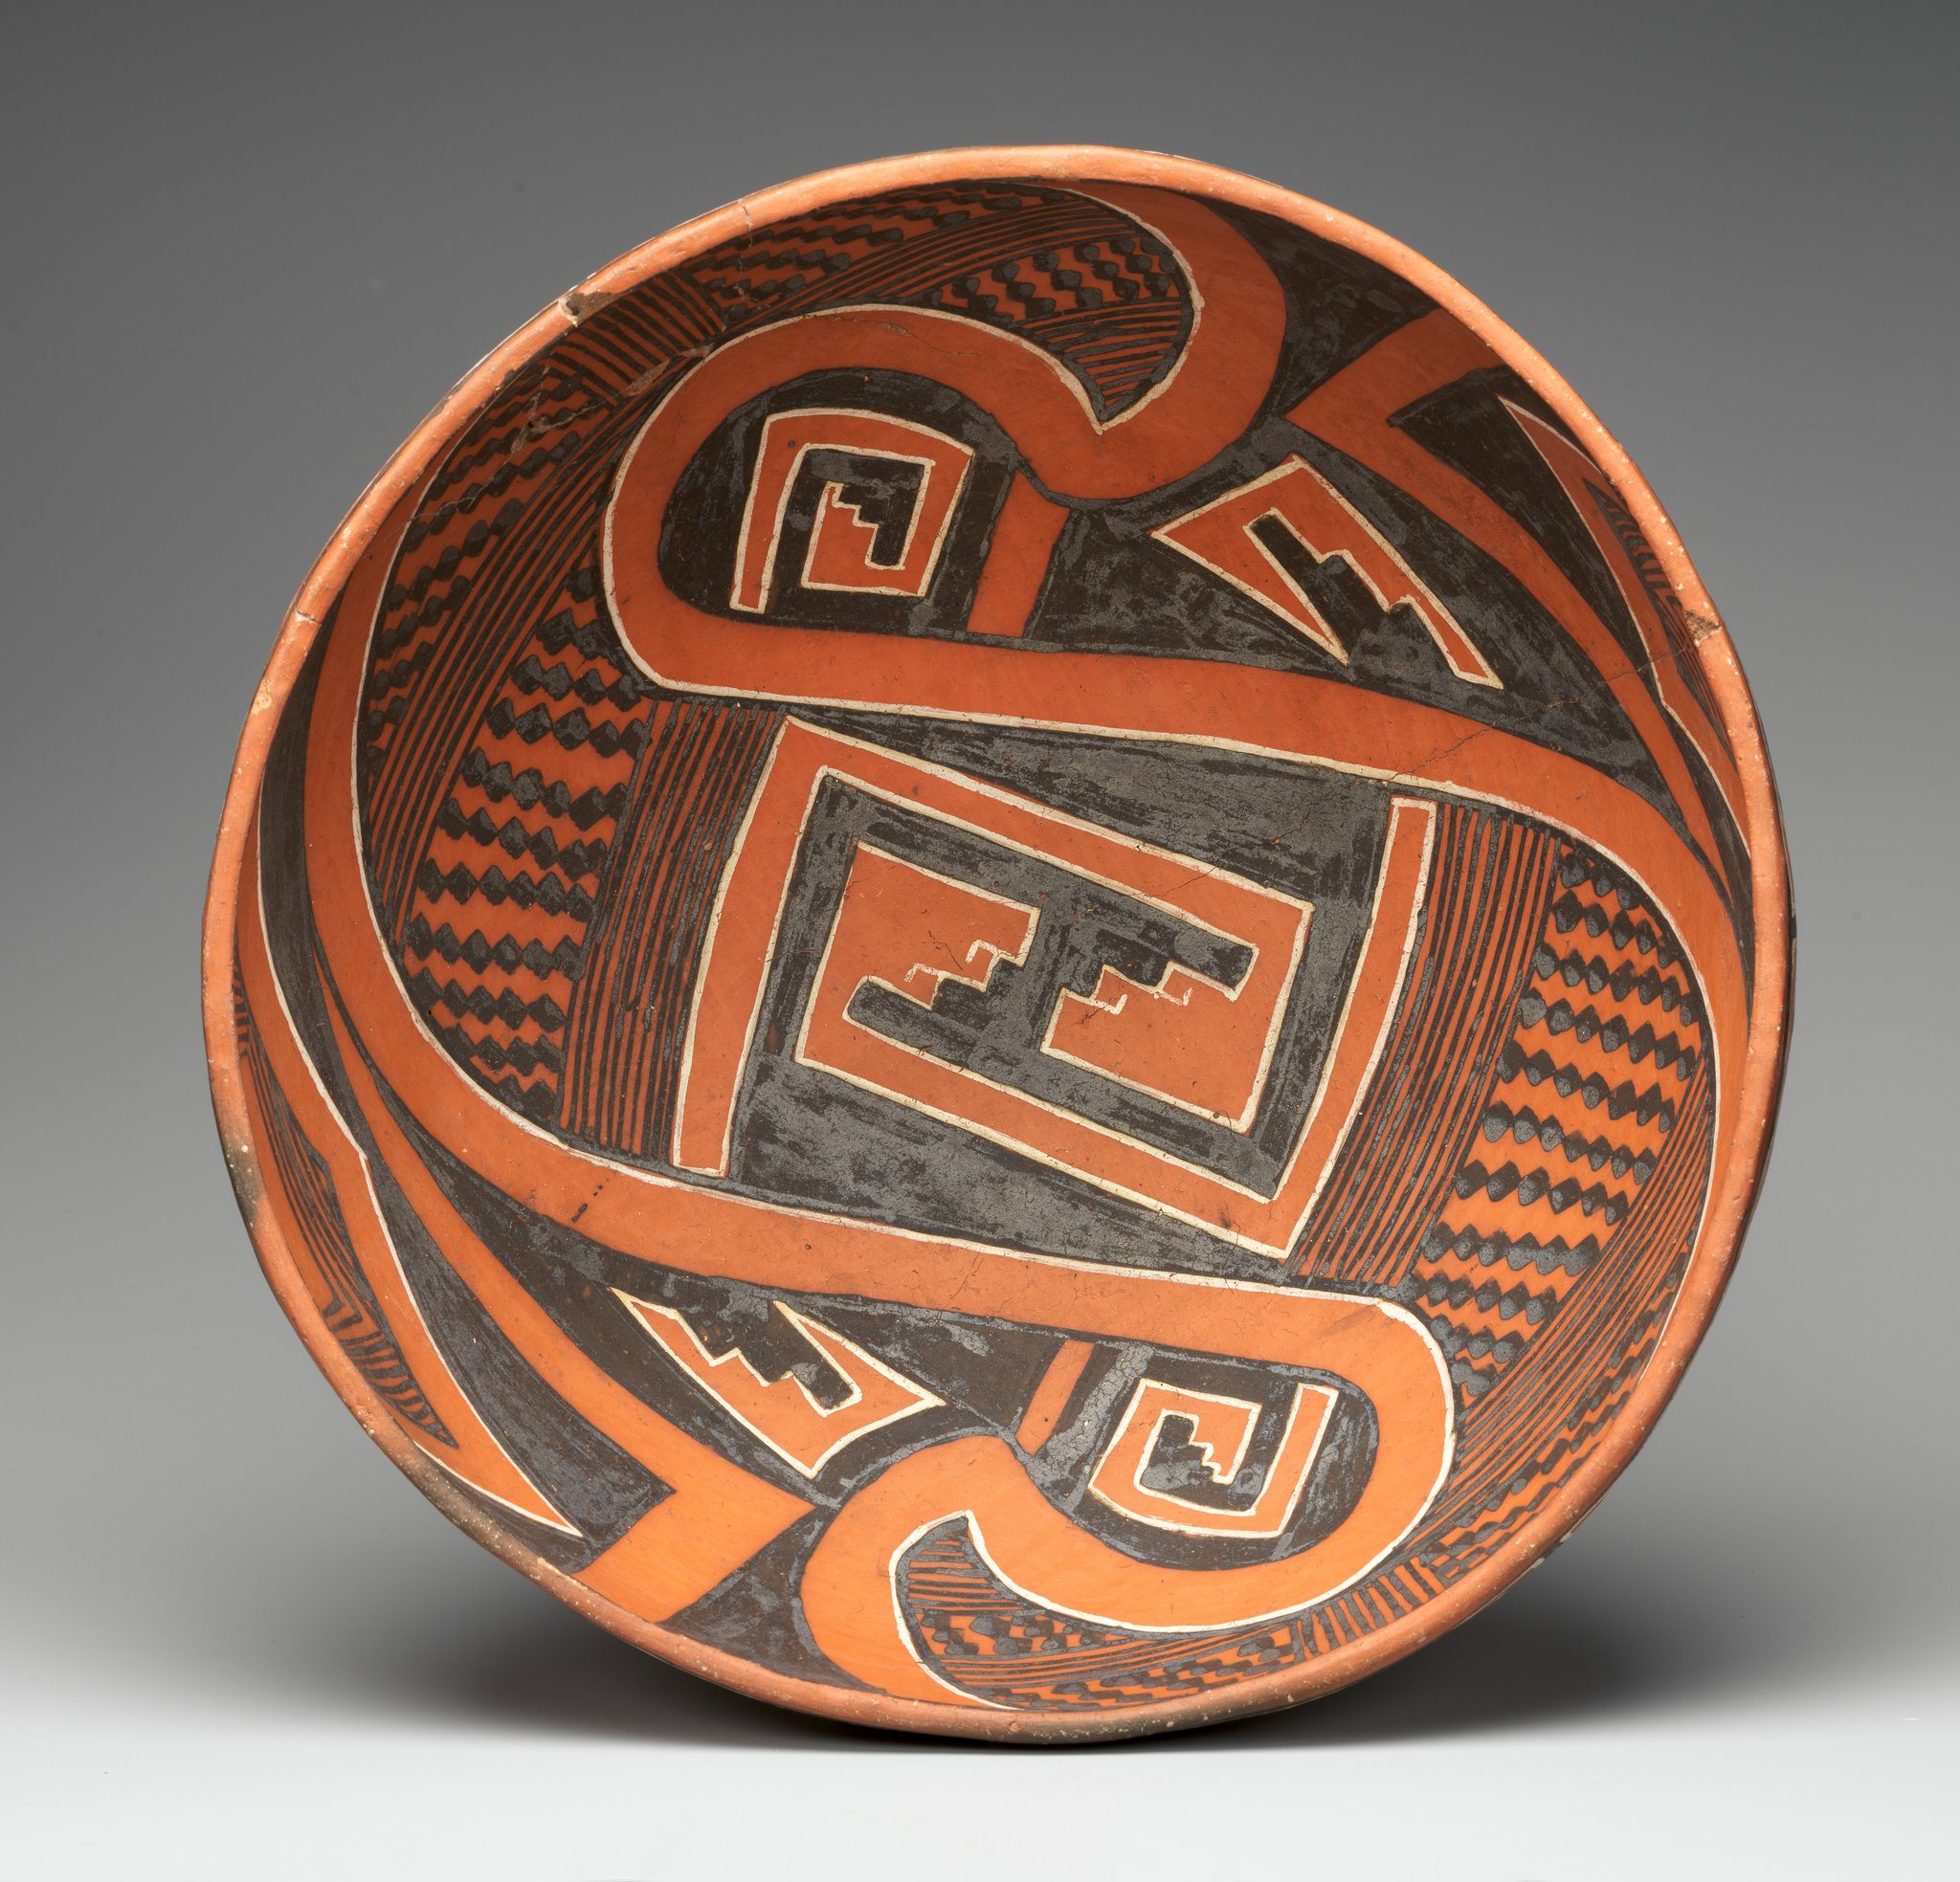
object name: bowl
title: Geometric Polychrome Bowl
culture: ancestral puebloan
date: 1301-1500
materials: clay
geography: united states